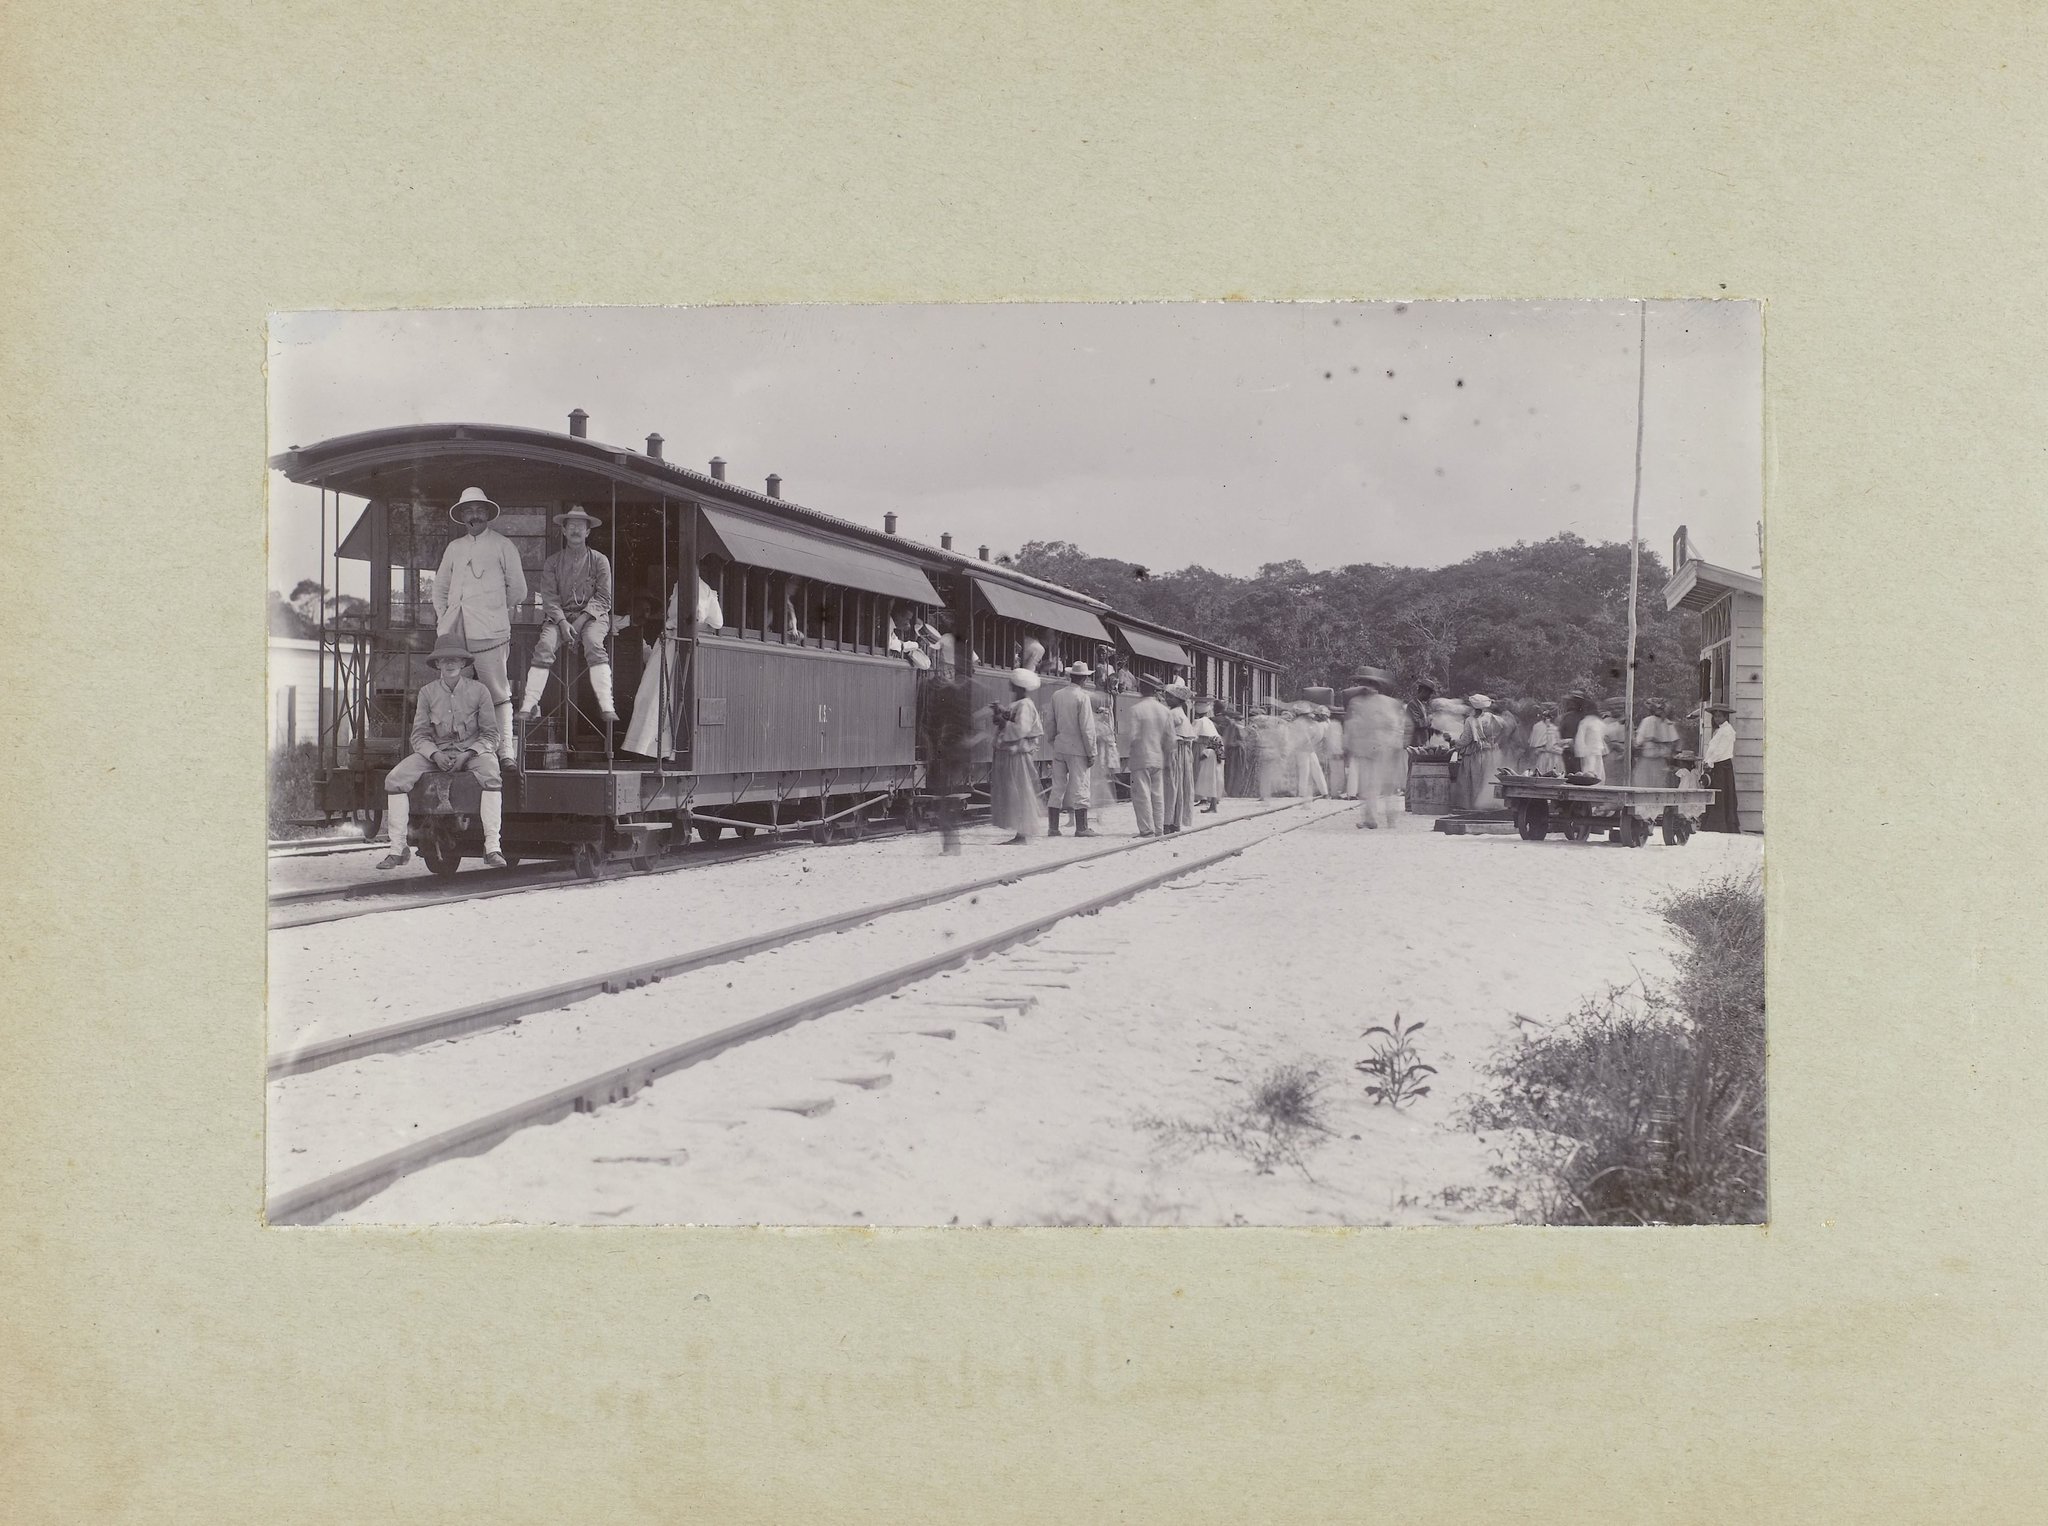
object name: photograph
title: Trein bij stationnetje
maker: augusta curiel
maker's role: fotograaf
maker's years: 1873-1937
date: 1905-1910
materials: photographic support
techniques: photography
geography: suriname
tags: jacob evert wesenhagen, railway, tramway; rack railway, suriname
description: Aankomst van een trein bij een station. Foto in het fotoalbum over de aanleg van de Lawaspoorweg in Suriname in de jaren 1903-1912. Onderdeel van een groep objecten afkomstig van de familie Wesenhagen in Suriname.